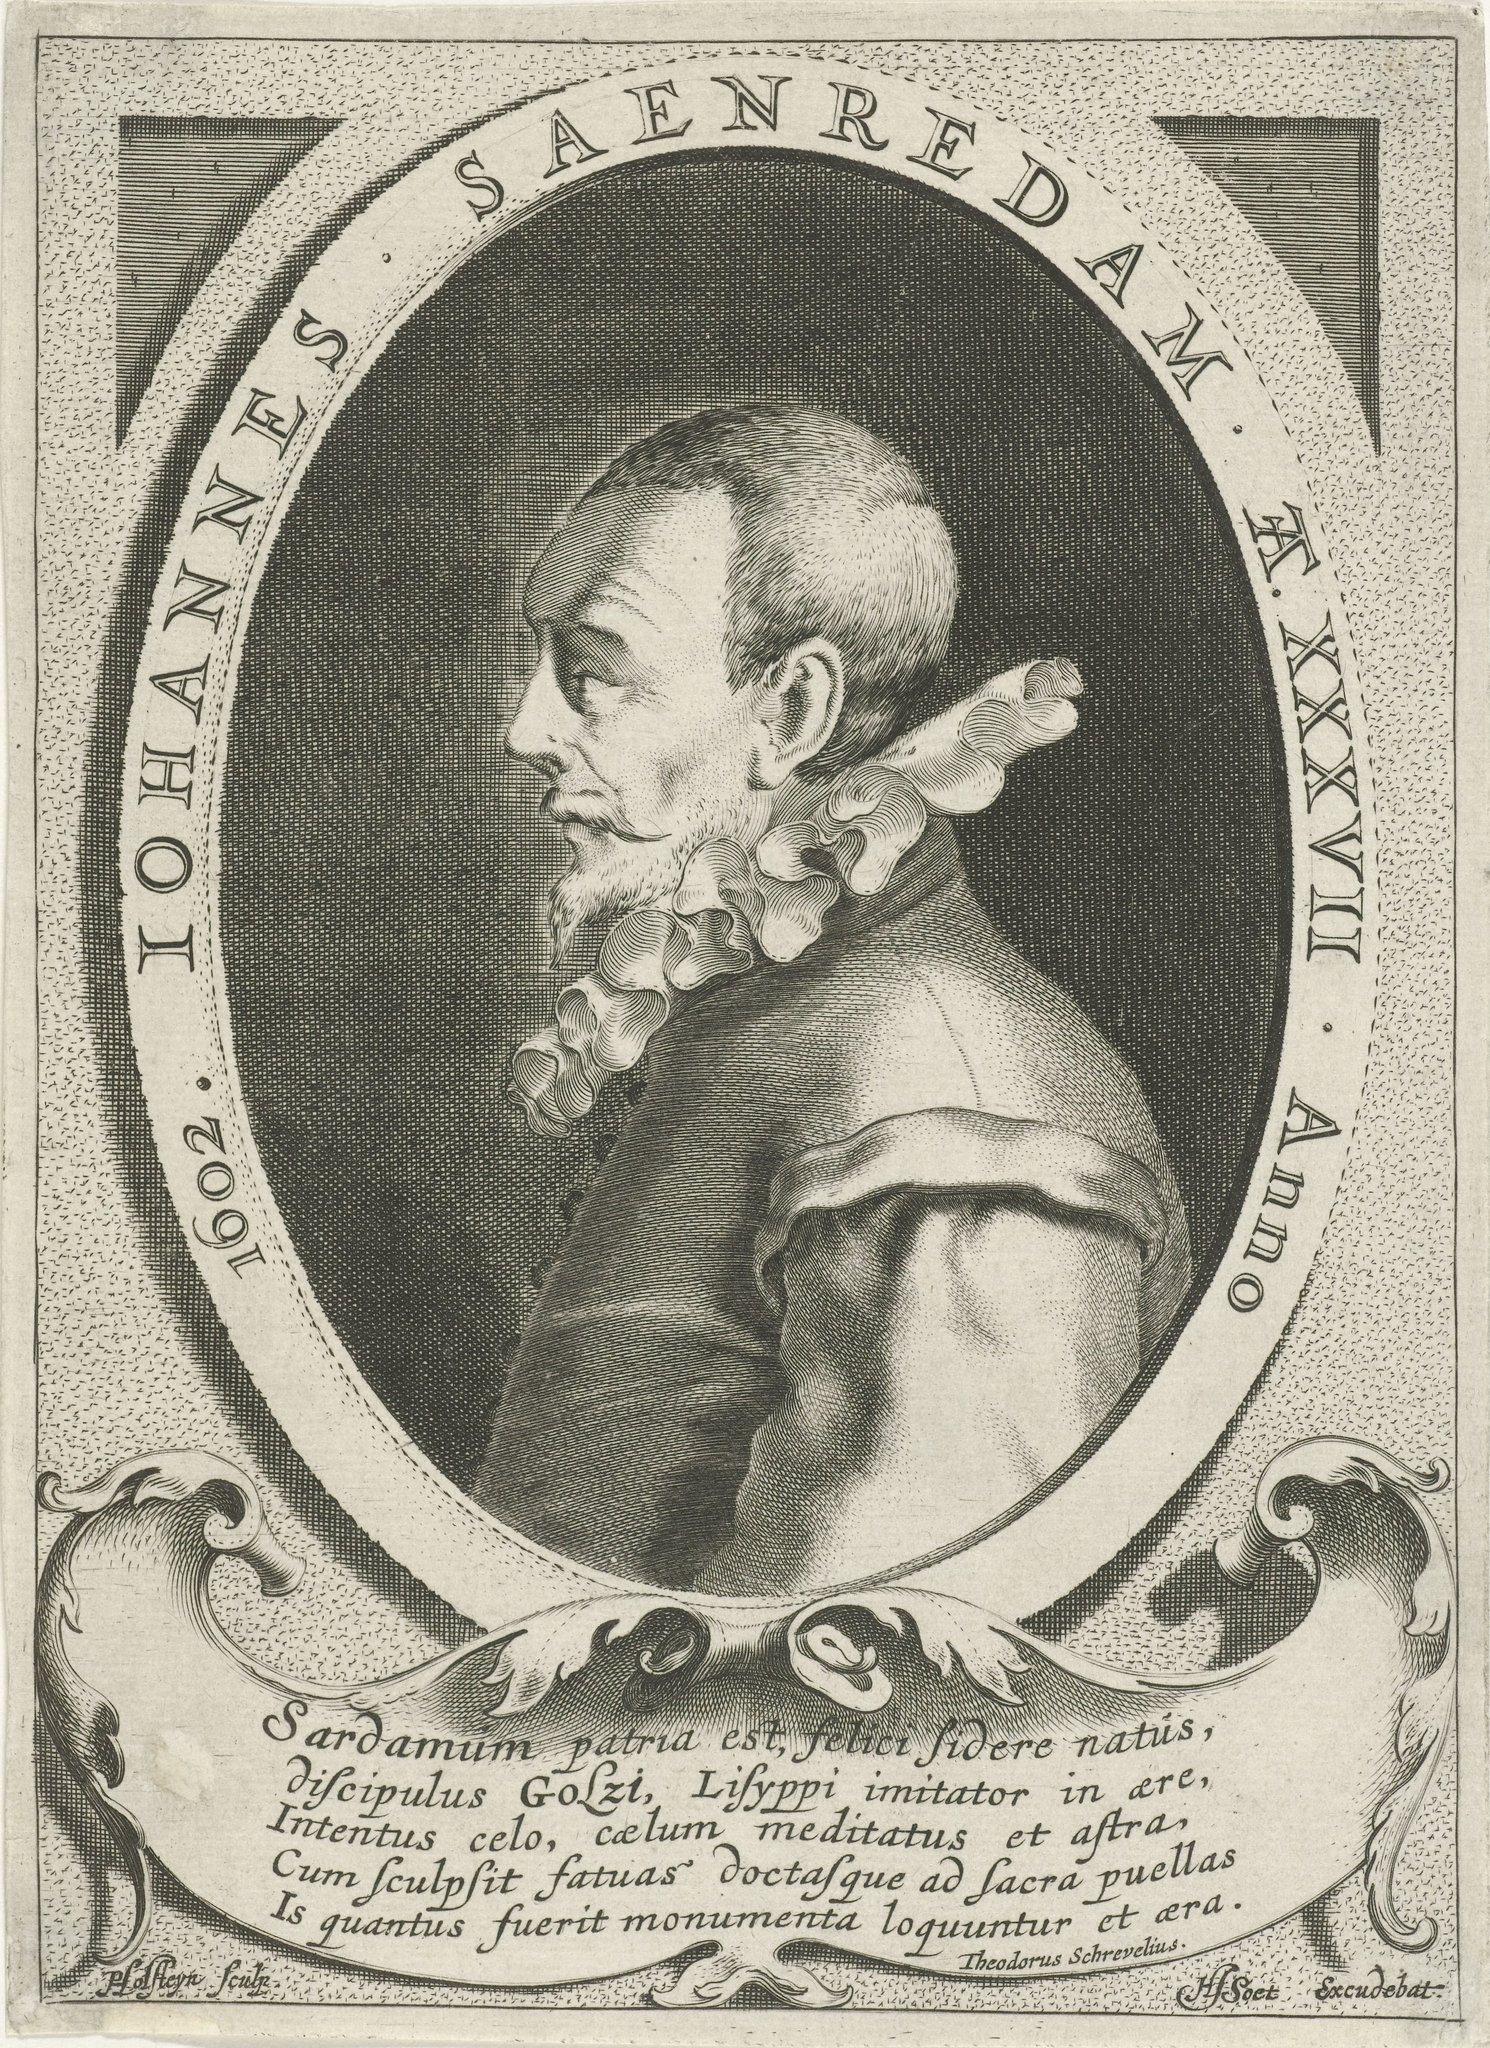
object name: print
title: Portret van Jan Saenredam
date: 1624-1649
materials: paper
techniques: engraving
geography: northern netherlands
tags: assendelft, print maker, draughtsman, jan saenredam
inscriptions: collector's mark: Lugt 2228, collector's mark: Lugt 2760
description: Buste naar links van Jan Saenredam op 37-jarige leeftijd in een ovaal met randschrift in het Latijn. Onder het portret vijf regels in het latijn op een cartouche.